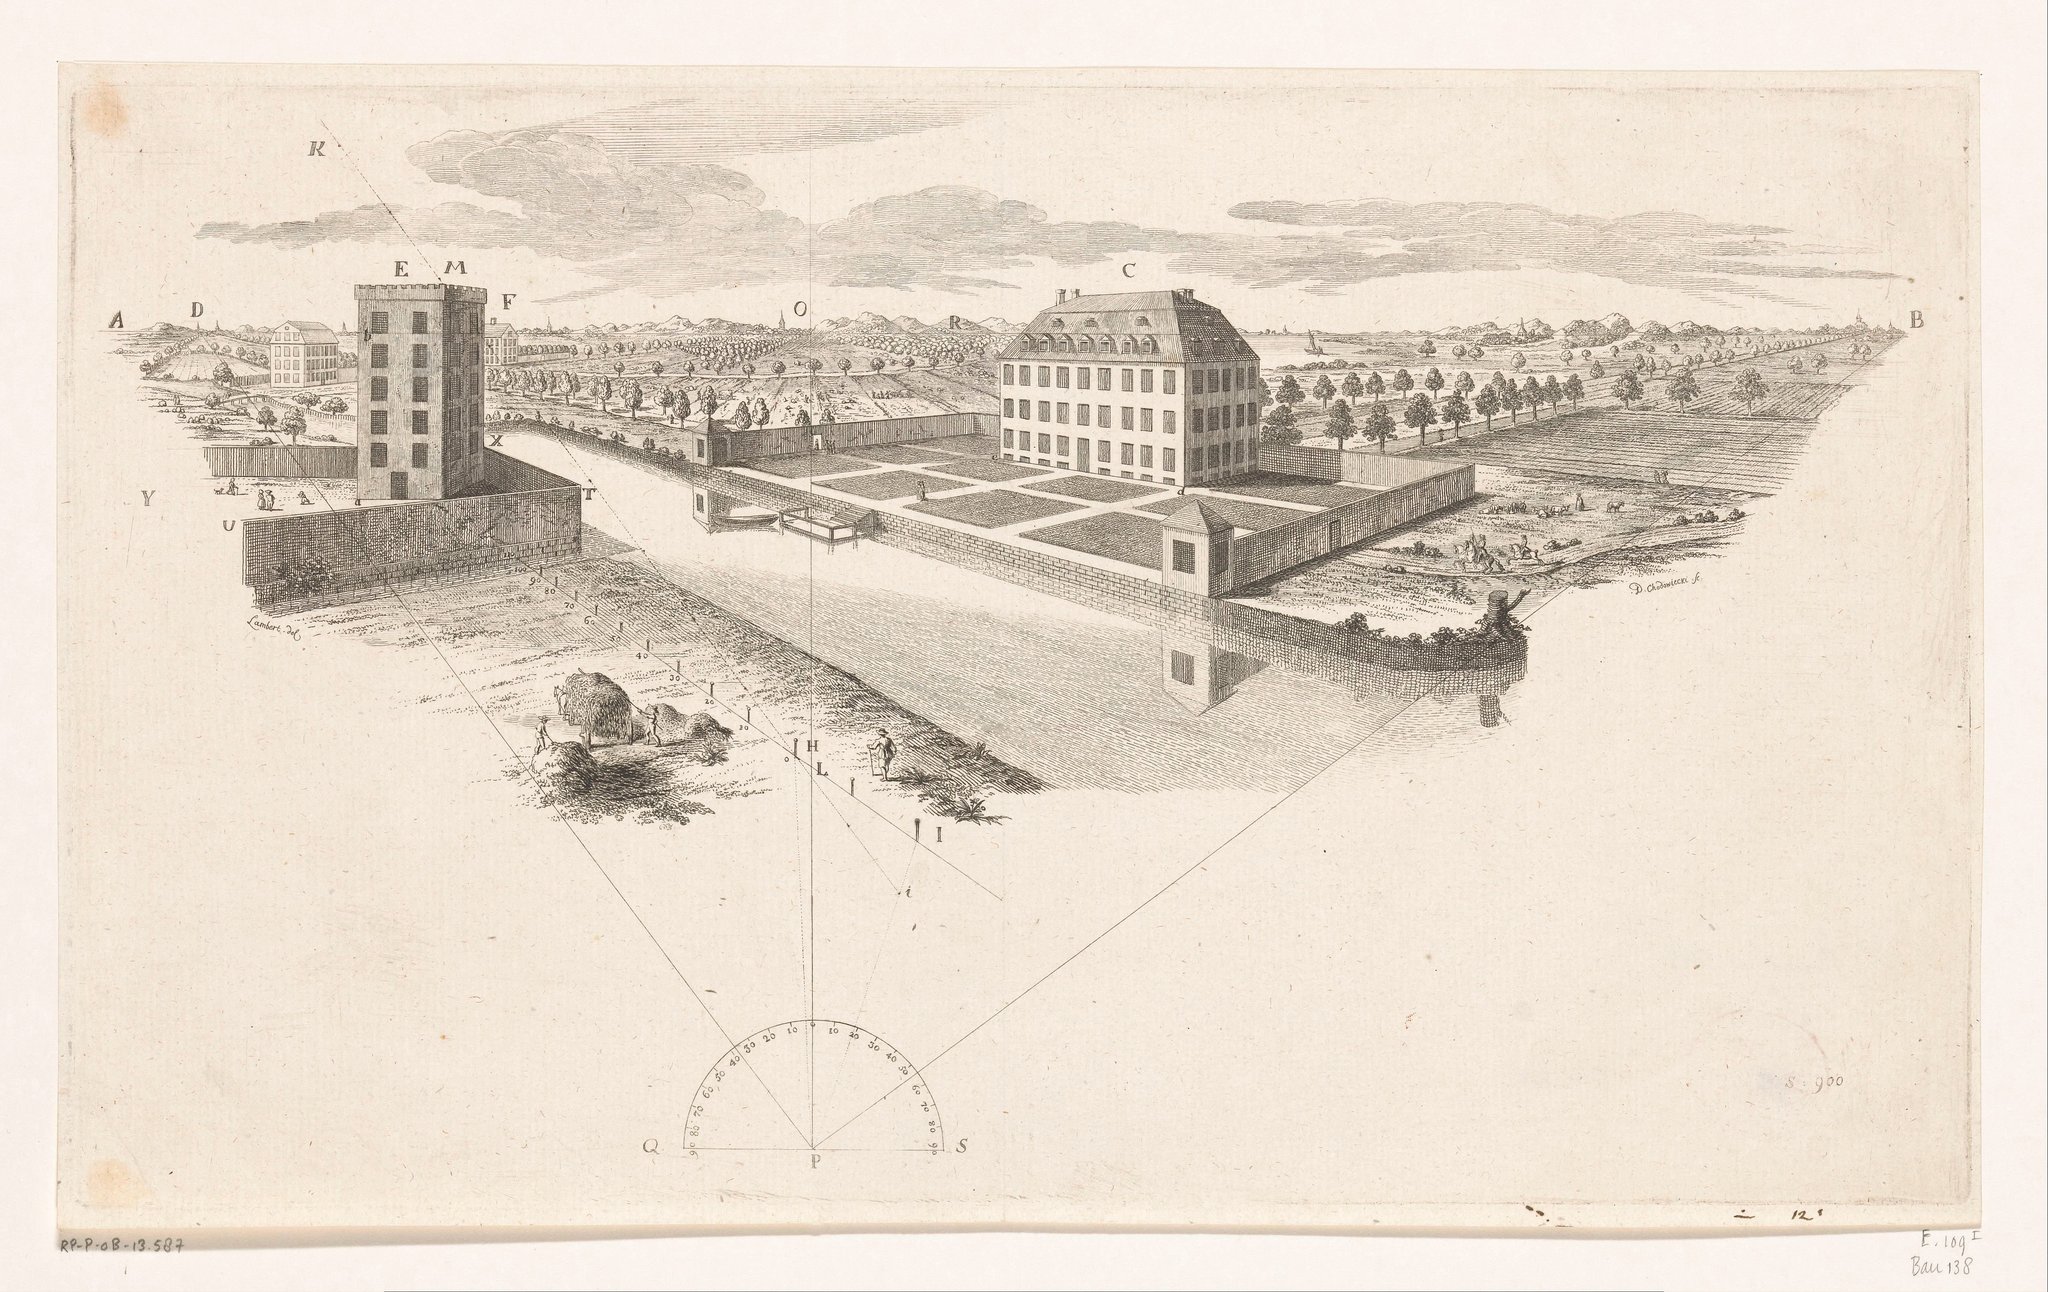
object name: print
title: Gebouwen in een landschap met lijnperspectief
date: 1774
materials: paper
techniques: etching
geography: berlin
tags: landscapes, civic architecture; edifices; dwellings, 'perspective' (alleg.); 'prospetiva' (ripa)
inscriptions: collector's mark: Lugt 700, collector's mark: Lugt 240, inscription: ‘- 12’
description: Ook gebruikt in: Sulzer, Johann Georg. Allgemeine Theorie der schönen Künste. Leipzig: erven M.G. Weidmann en Reich, 1774, dl. 2.